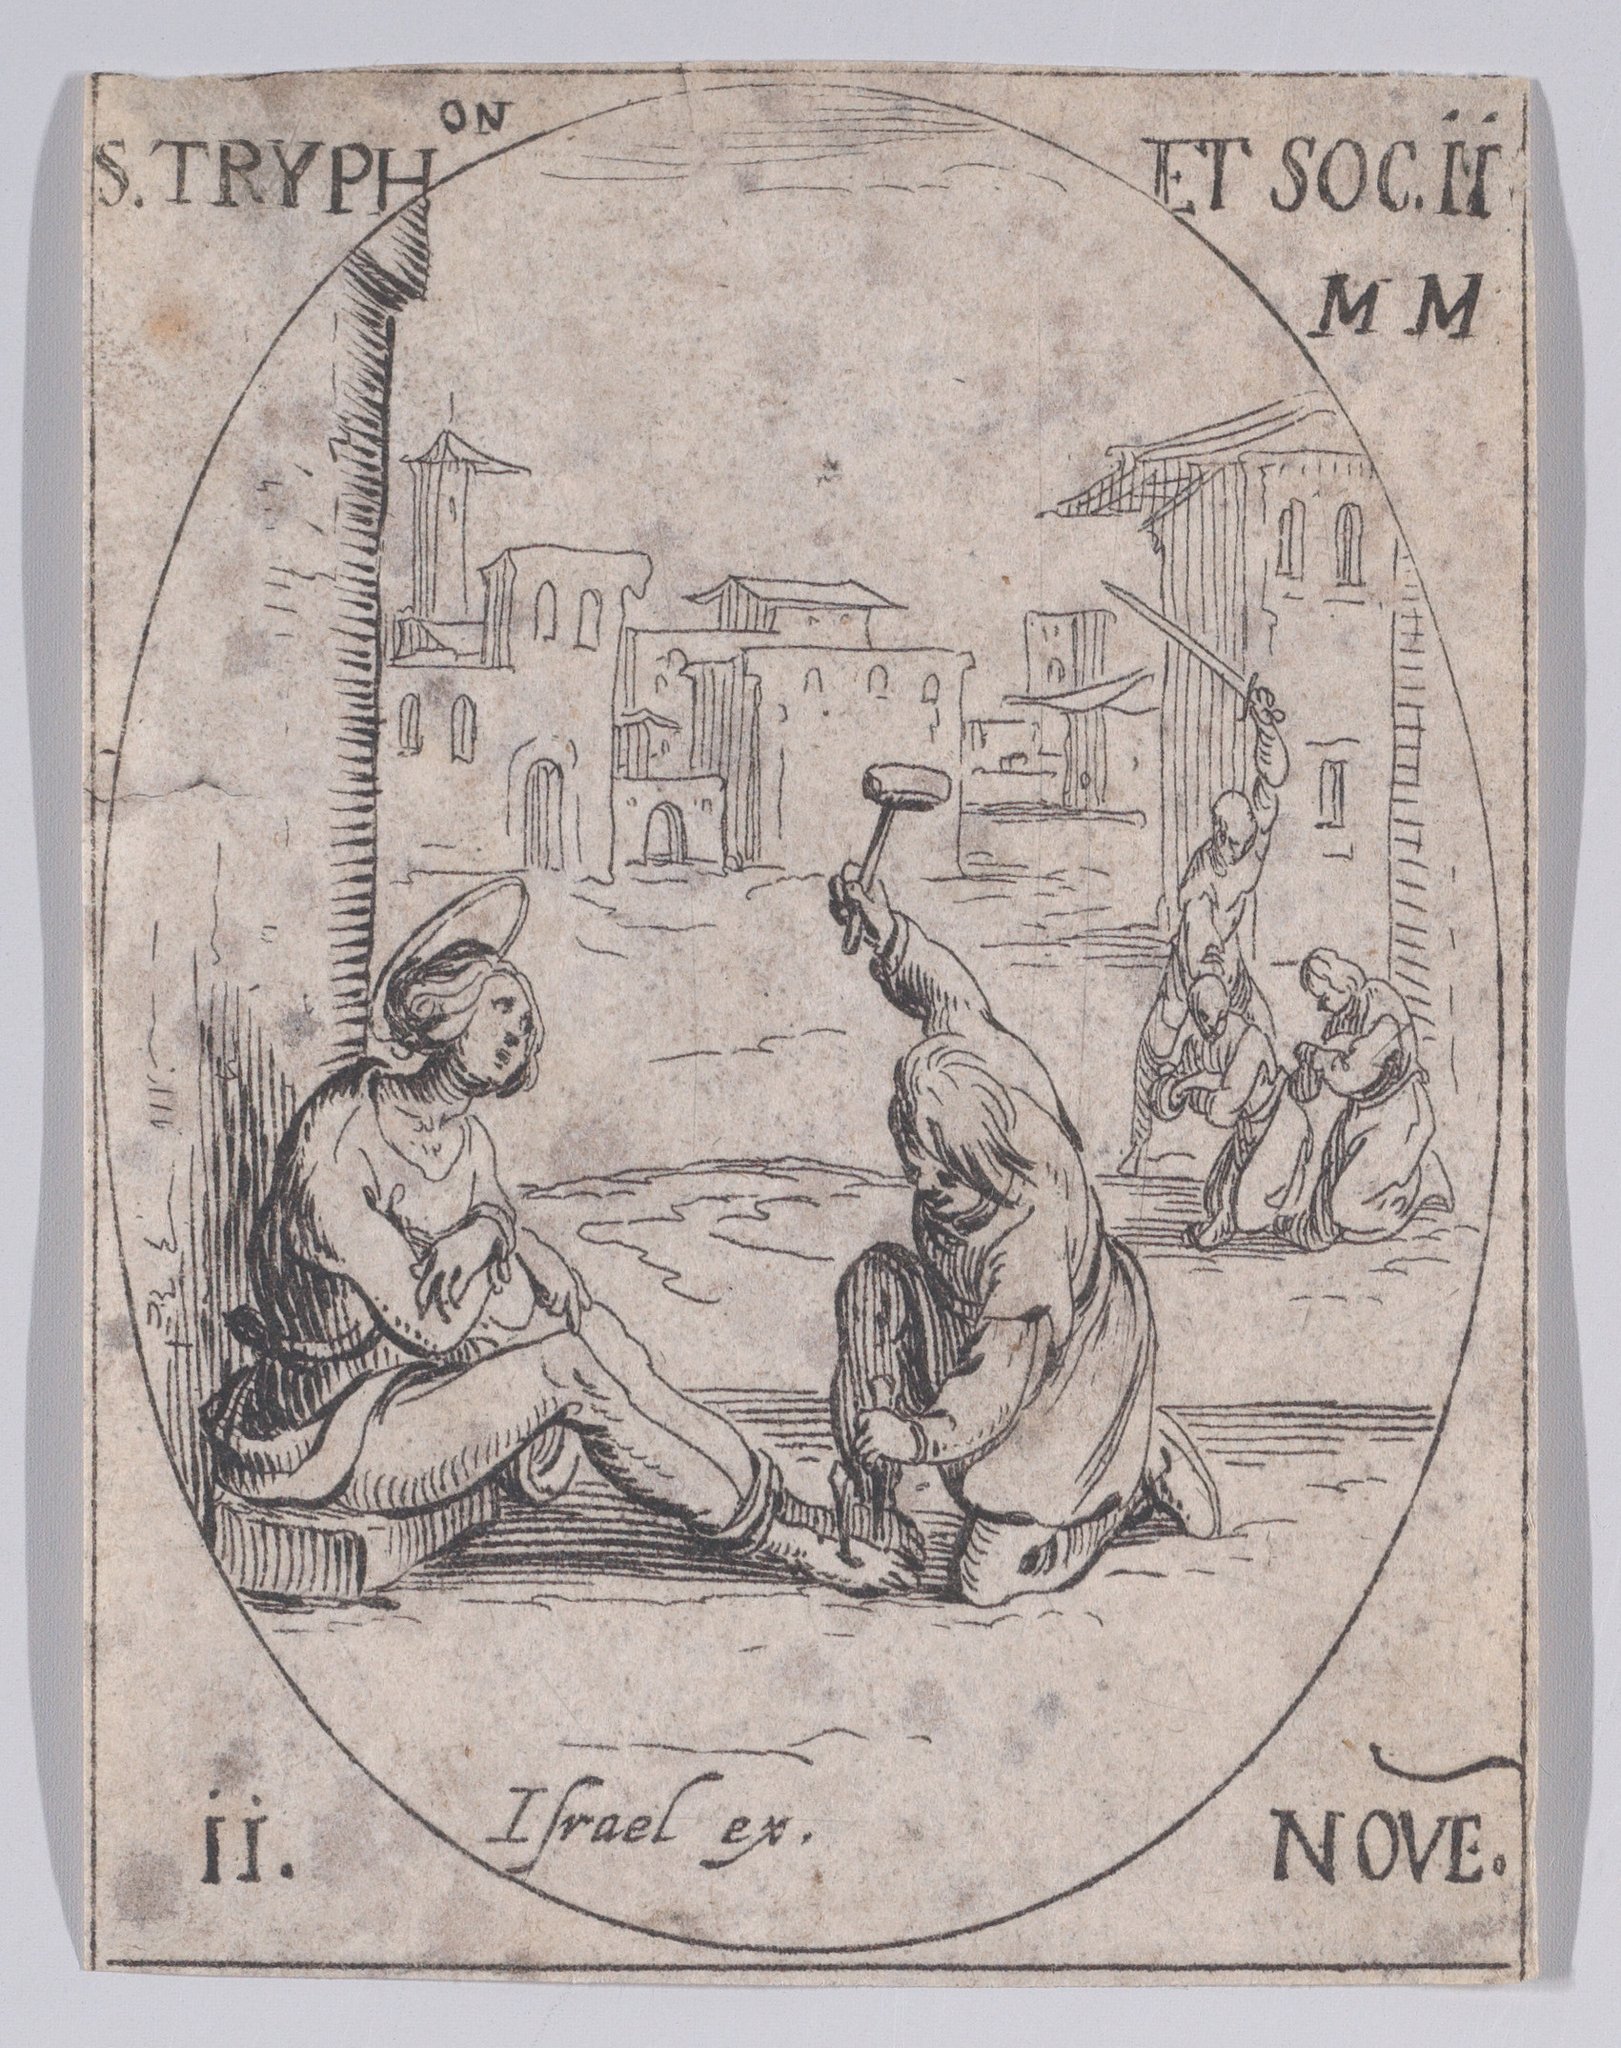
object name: print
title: S. Tryphon et Ses Compagnons (St. Tryphon and His Companions), November 11th, from "Les Images De Tous Les Saincts et Saintes de L'Année" (Images of All of the Saints and Religious Events of the Year)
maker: jacques callot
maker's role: artist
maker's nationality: french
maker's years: 1592-1635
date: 1636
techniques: etching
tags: men,saints